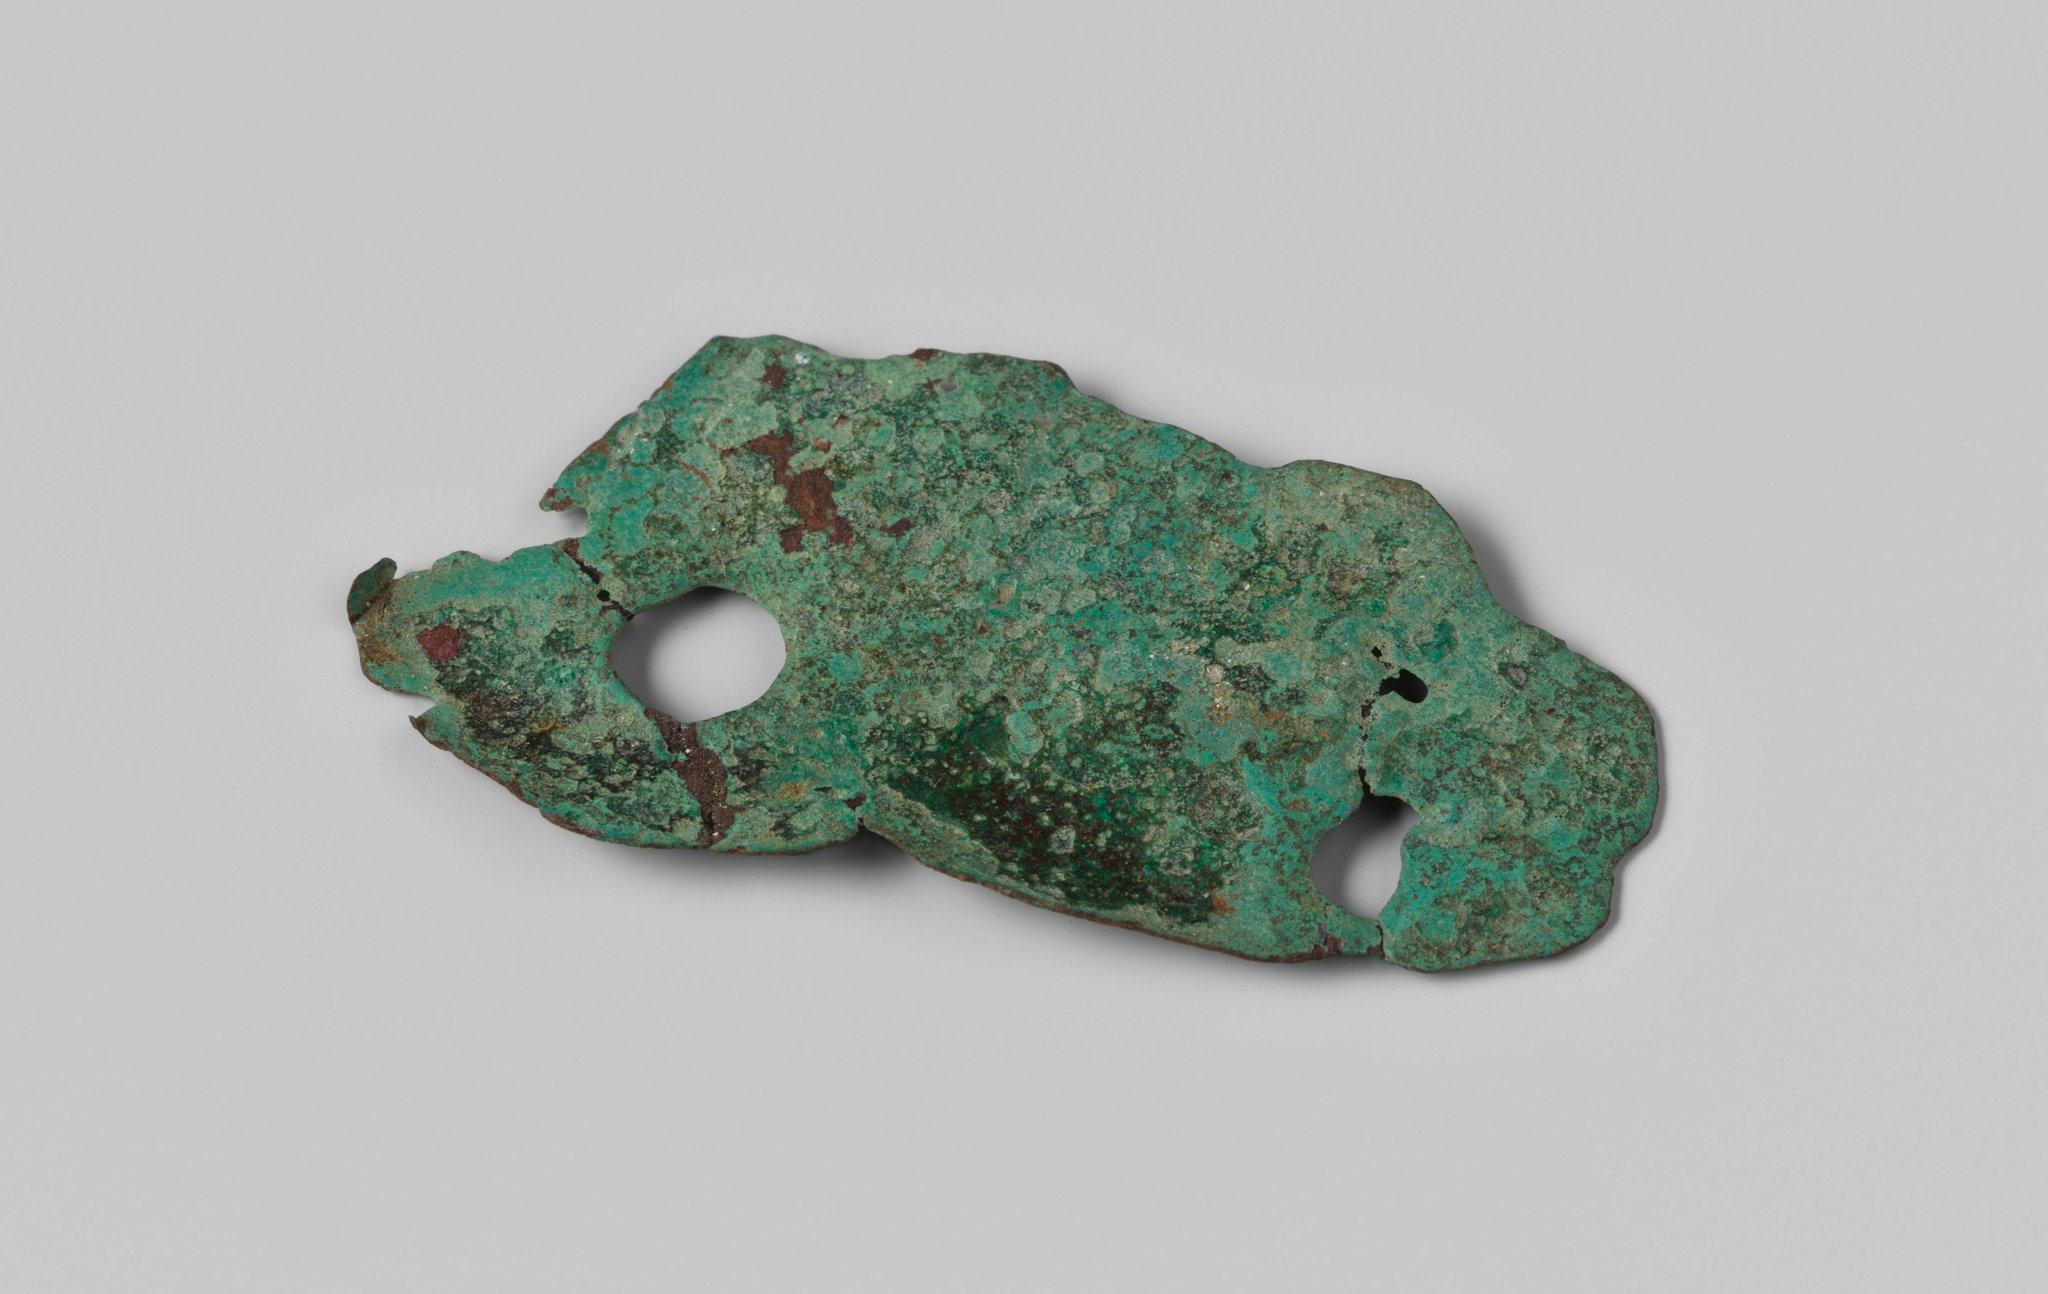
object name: plaatwerk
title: Fragment plaatwerk uit het wrak van de Oostindiëvaarder Hollandia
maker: Anonymous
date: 1700-1743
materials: copper